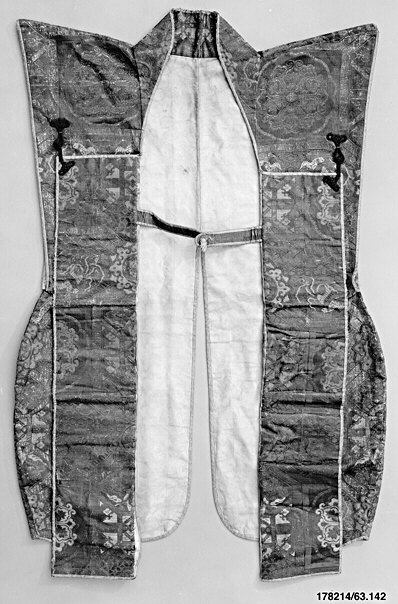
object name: man's overvest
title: Jimbaori with shokko diaper pattern of dragons, phoenix birds, and stylized "Chinese flowers"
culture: japanese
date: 1801-1900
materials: silk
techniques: brocade